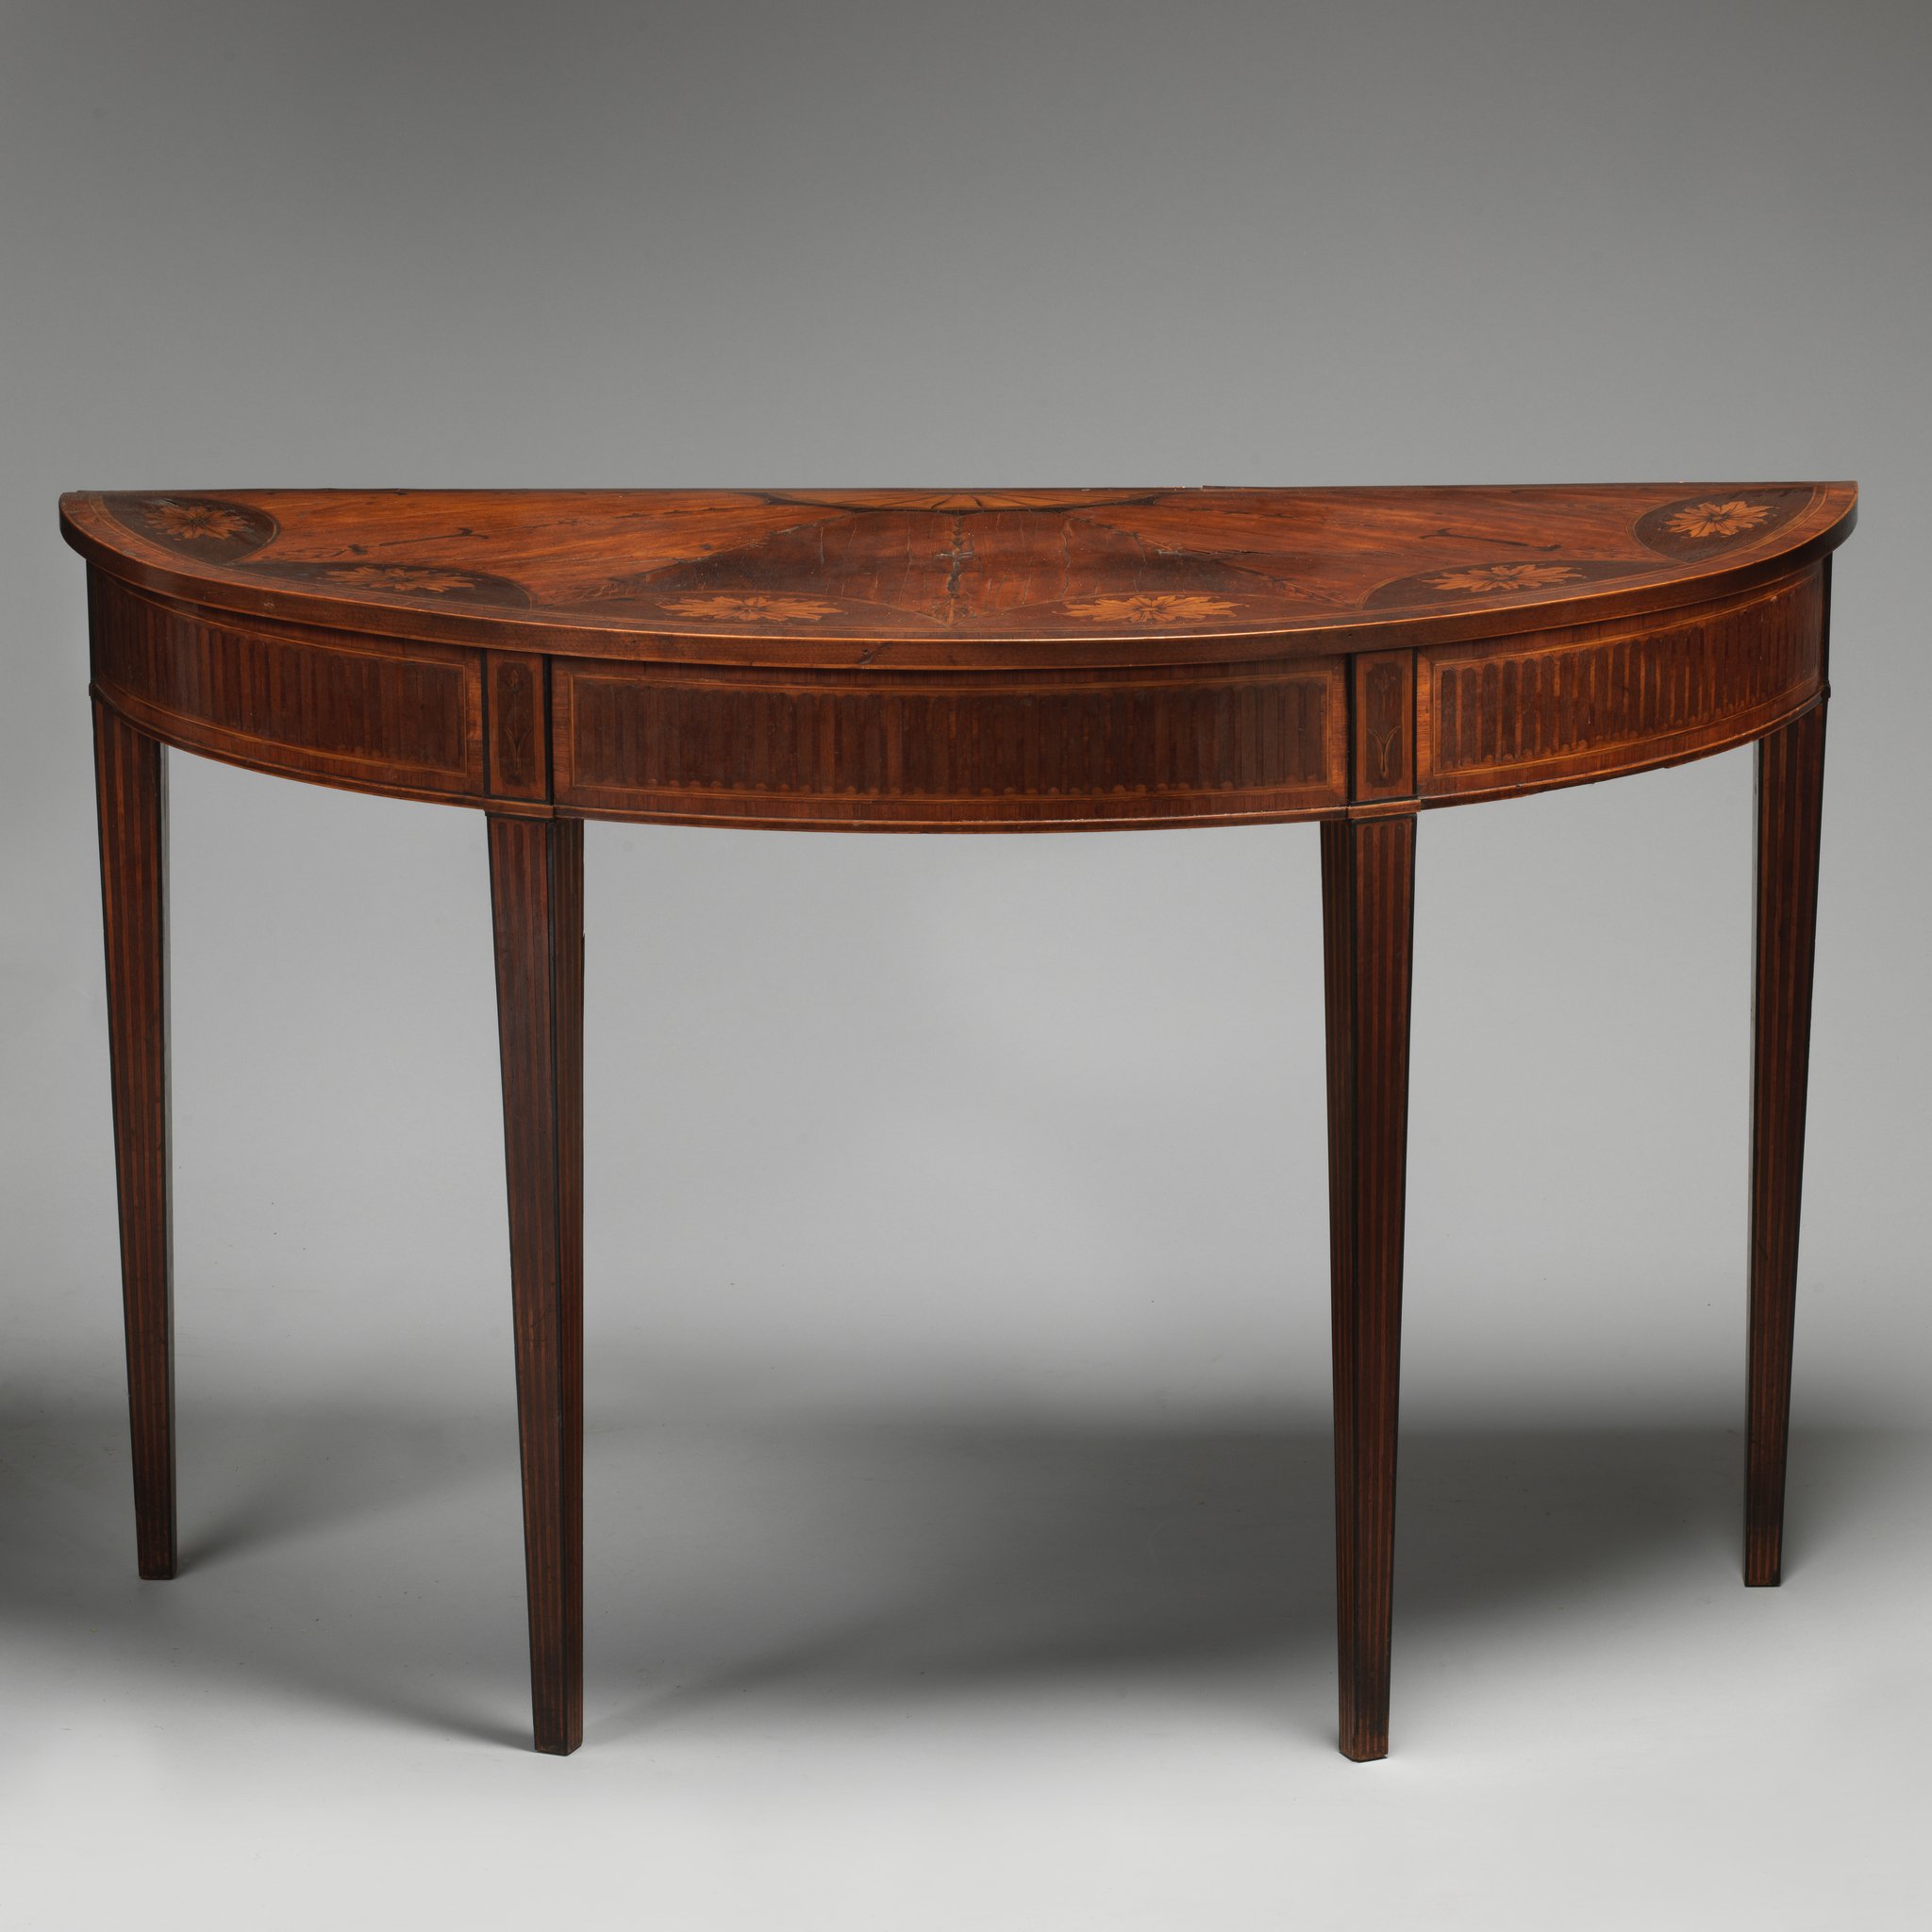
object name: side table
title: Side table (one of a pair)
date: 1790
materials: wood